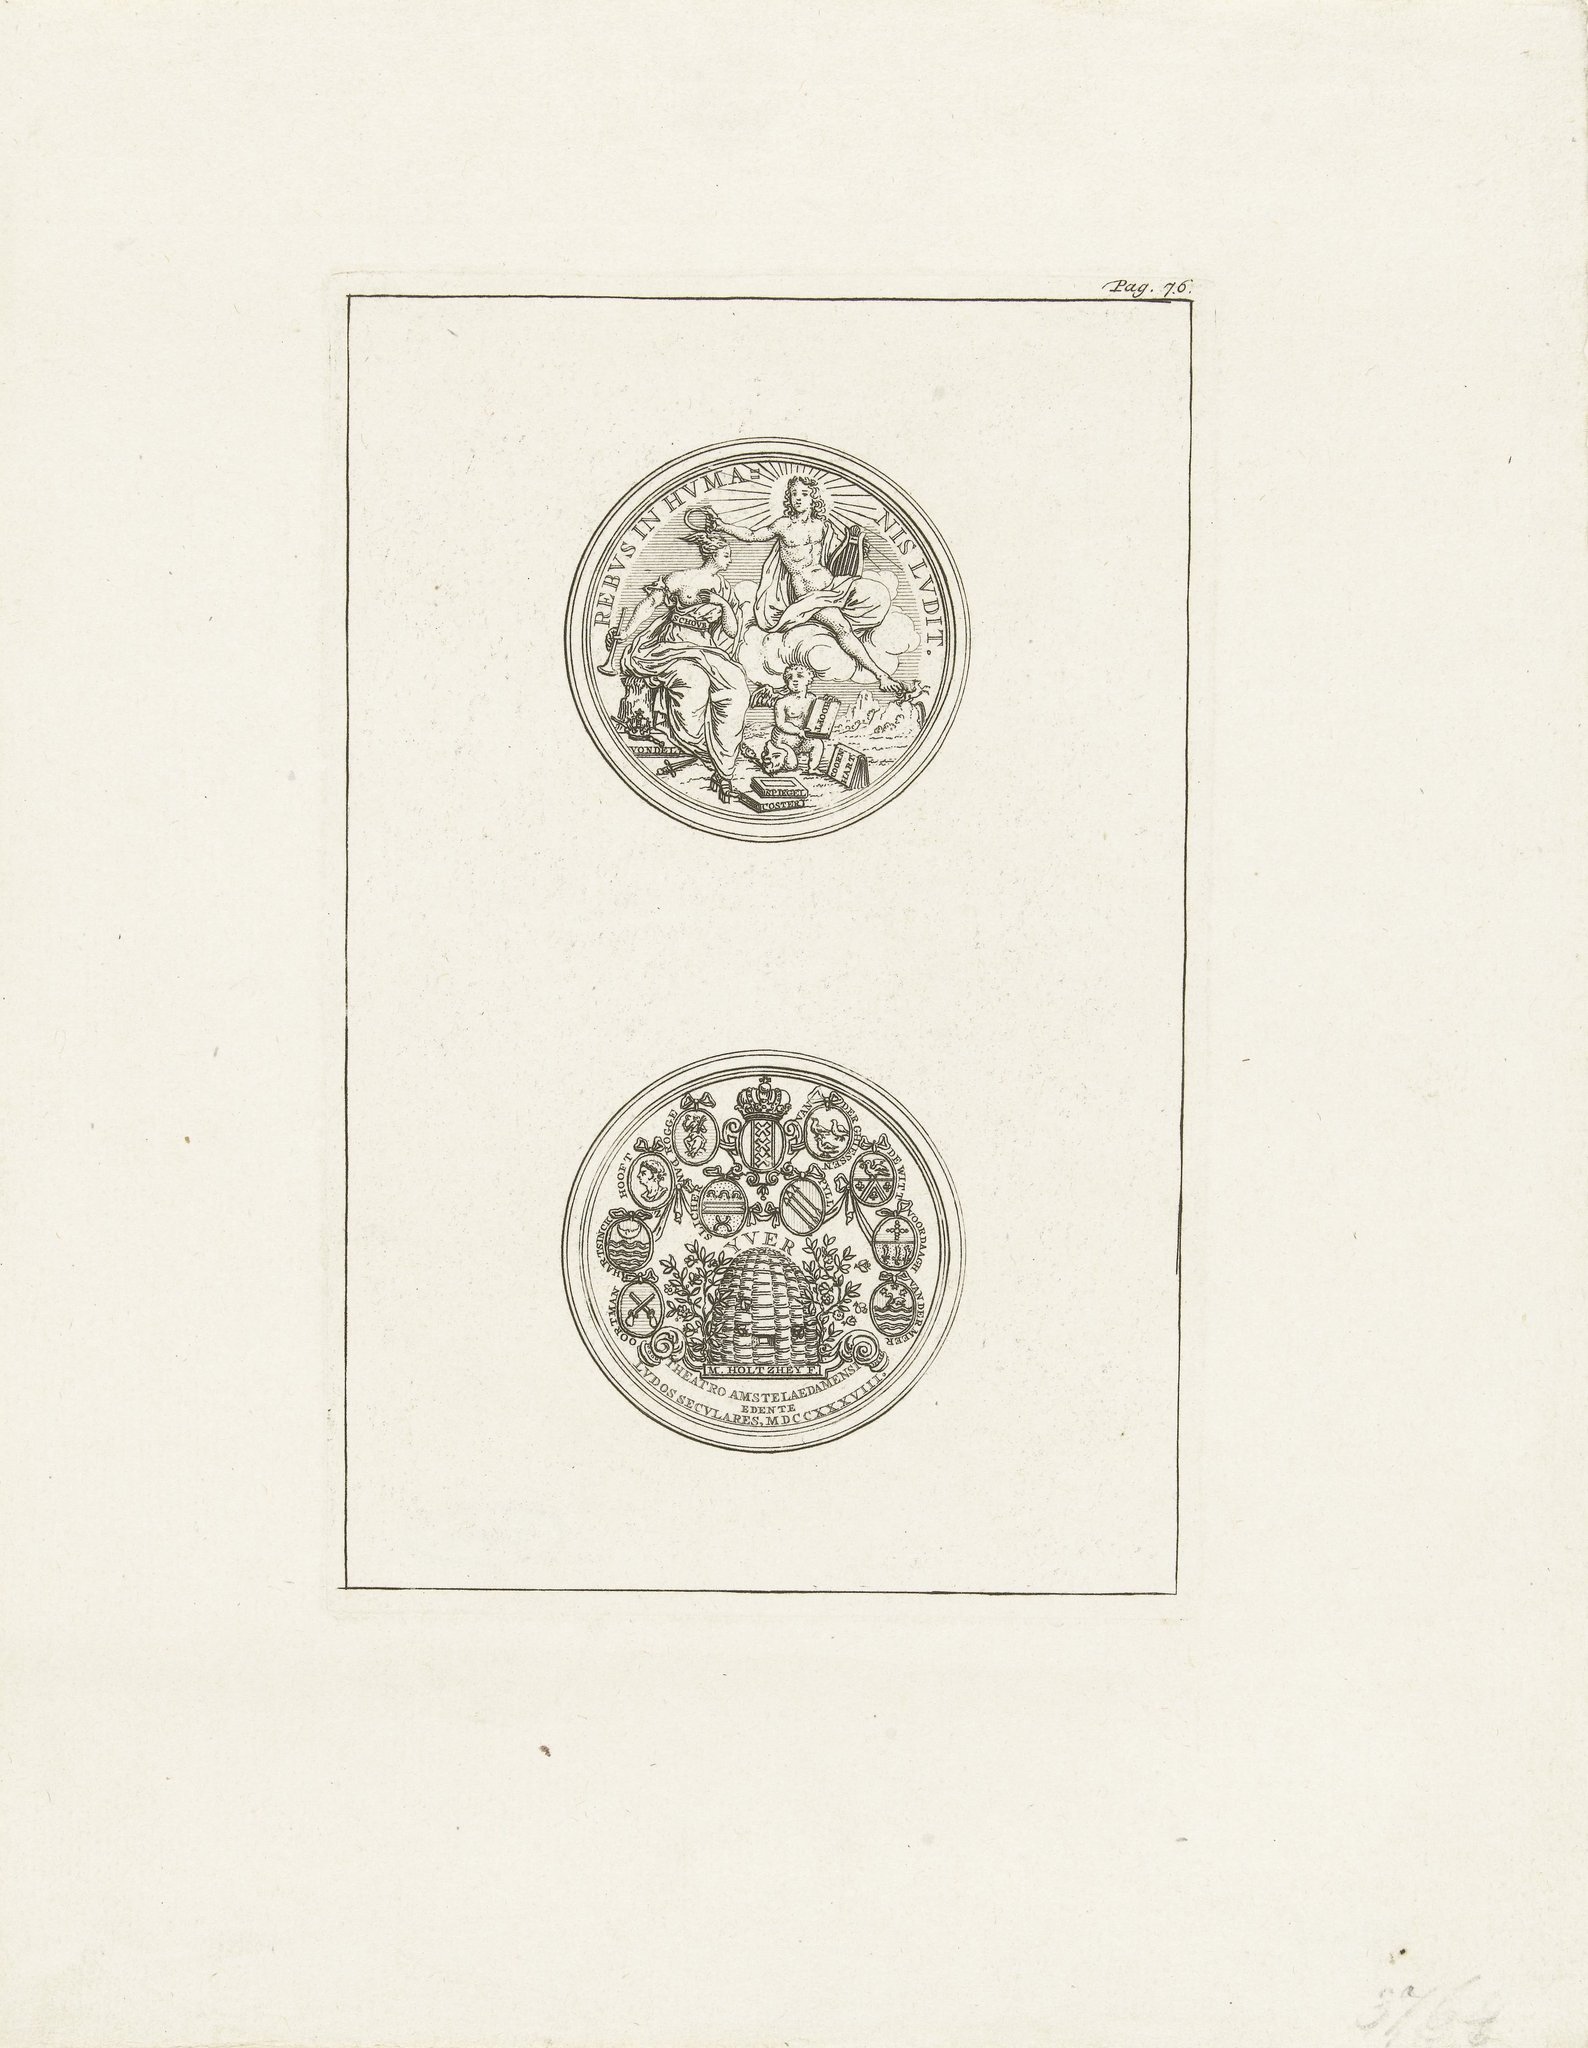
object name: print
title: Penning op het eeuwfeest van de Amsterdamse Schouwburg, 1738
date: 1738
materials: paper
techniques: etching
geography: northern netherlands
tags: medal (considered as a piece of sculpture, regardless of its specific function)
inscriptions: collector's mark: Lugt 2228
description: De beide zijden van een penning geslagen ter ere van het eerste eeuwfeest van de Amsterdamse Schouwburg, 1738. Gemerkt rechtsboven: Pag. 76.